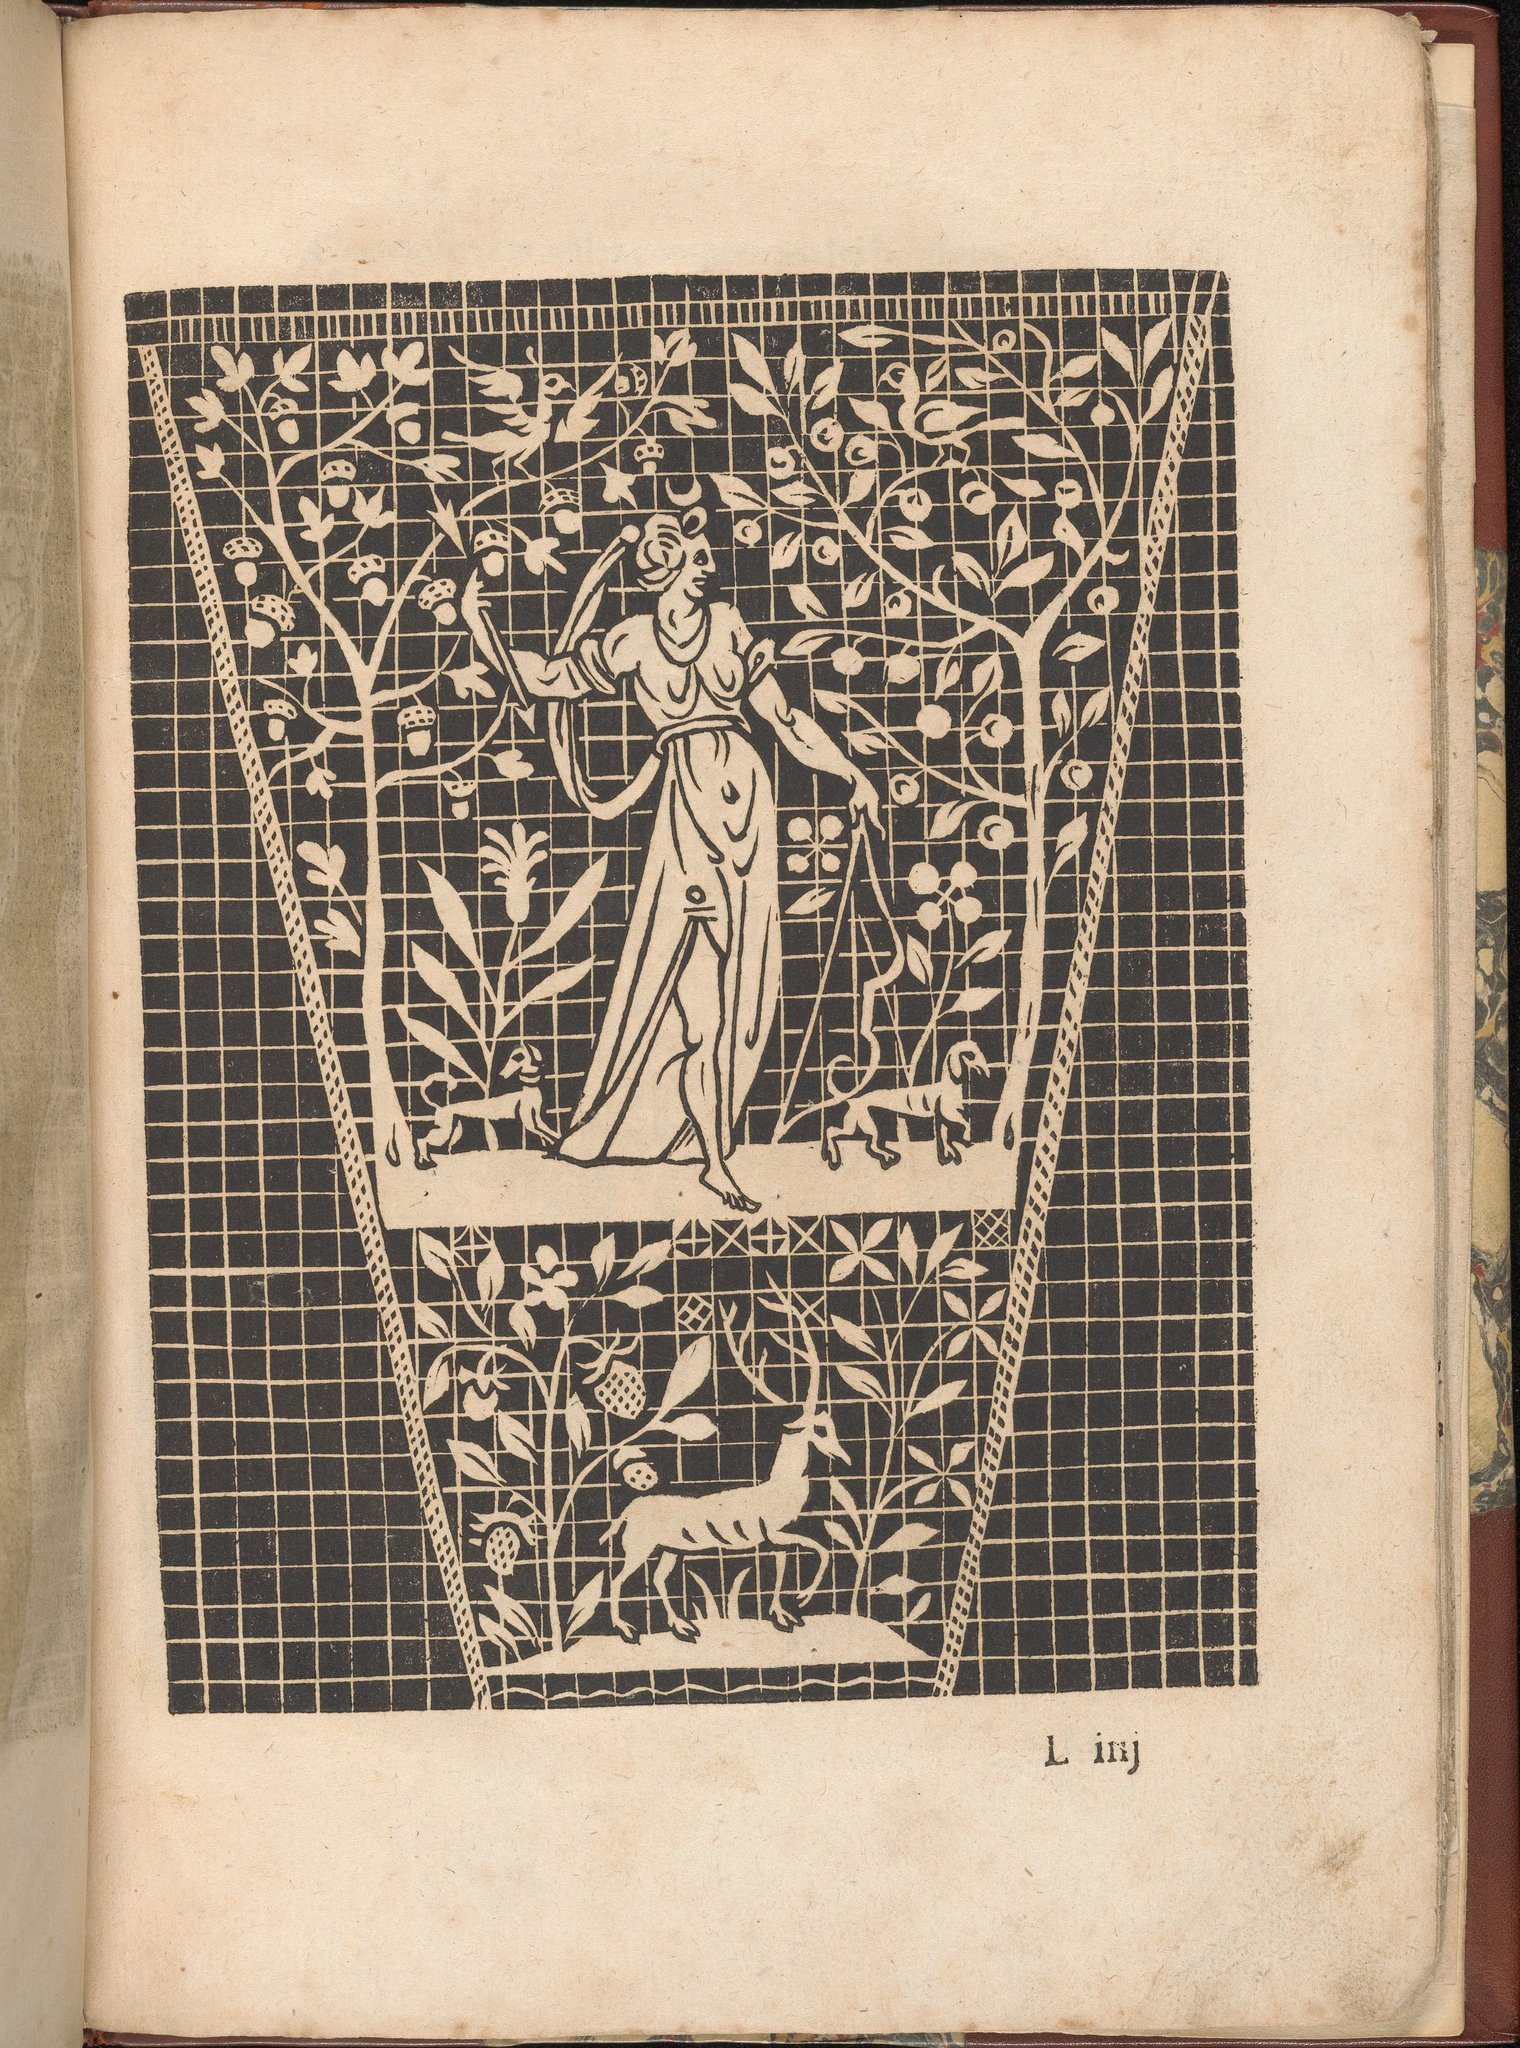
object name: book print ornament architecture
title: Les Secondes Oeuvres, et Subtiles Inventions De Lingerie du Seigneur Federic de Vinciolo Venitien, page 44 (recto)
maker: federico de vinciolo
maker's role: designer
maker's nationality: italian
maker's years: 1582-1599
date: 1603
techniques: woodcut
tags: birds,bow and arrow,women,deer,dogs,plants,acorns,trees